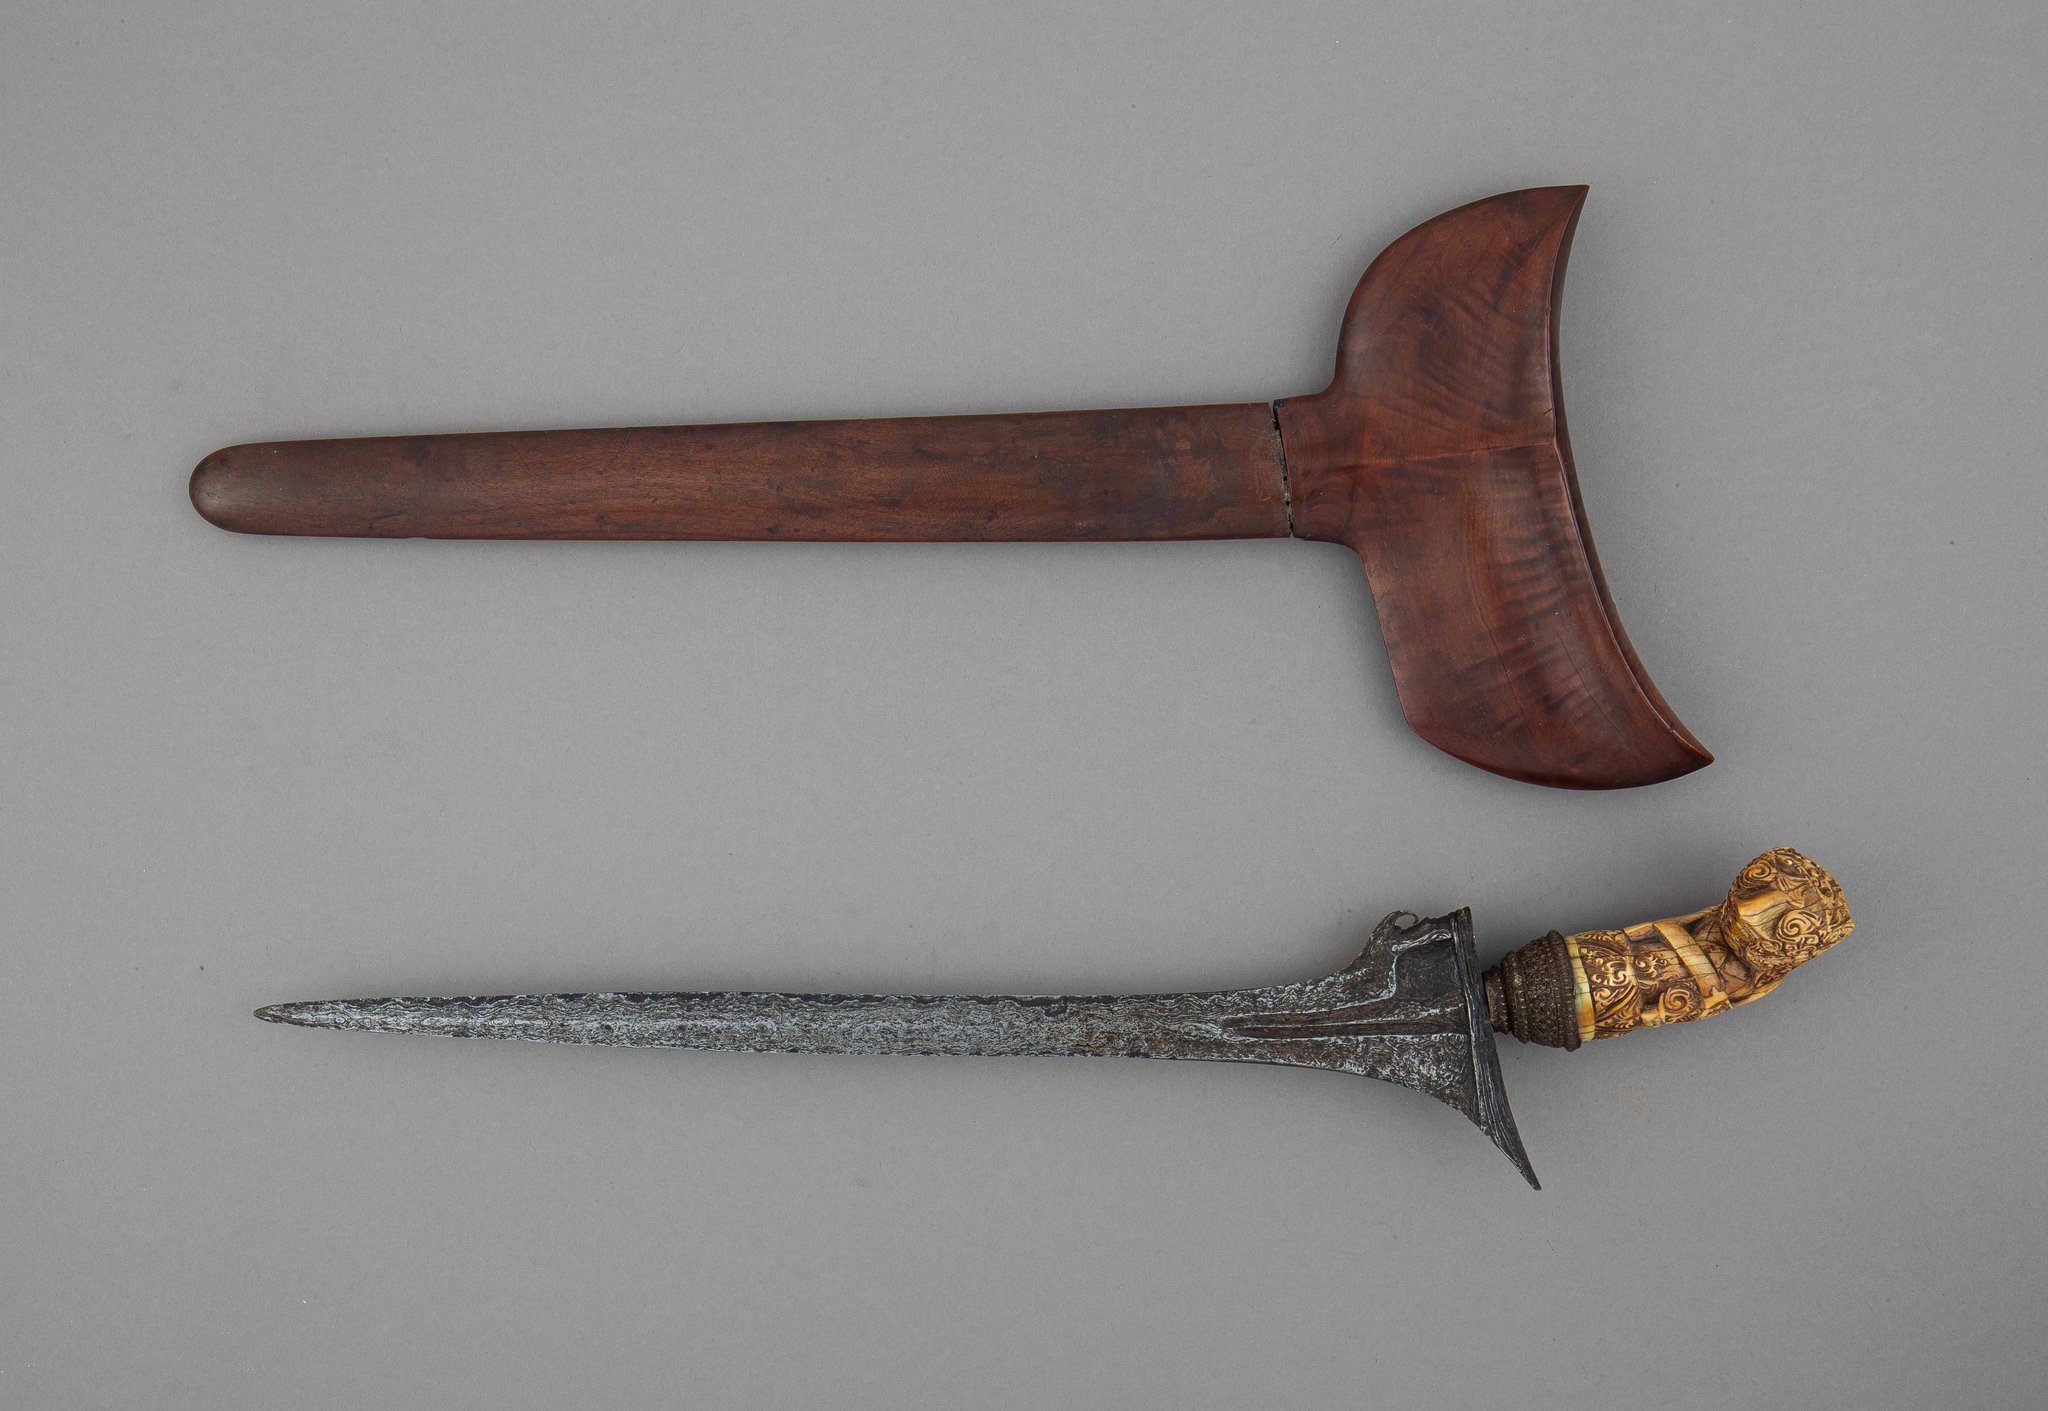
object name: kris with sheath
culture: indonesian, sumbawa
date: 1701-1900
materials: copper, ivory, steel, wood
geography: indonesia